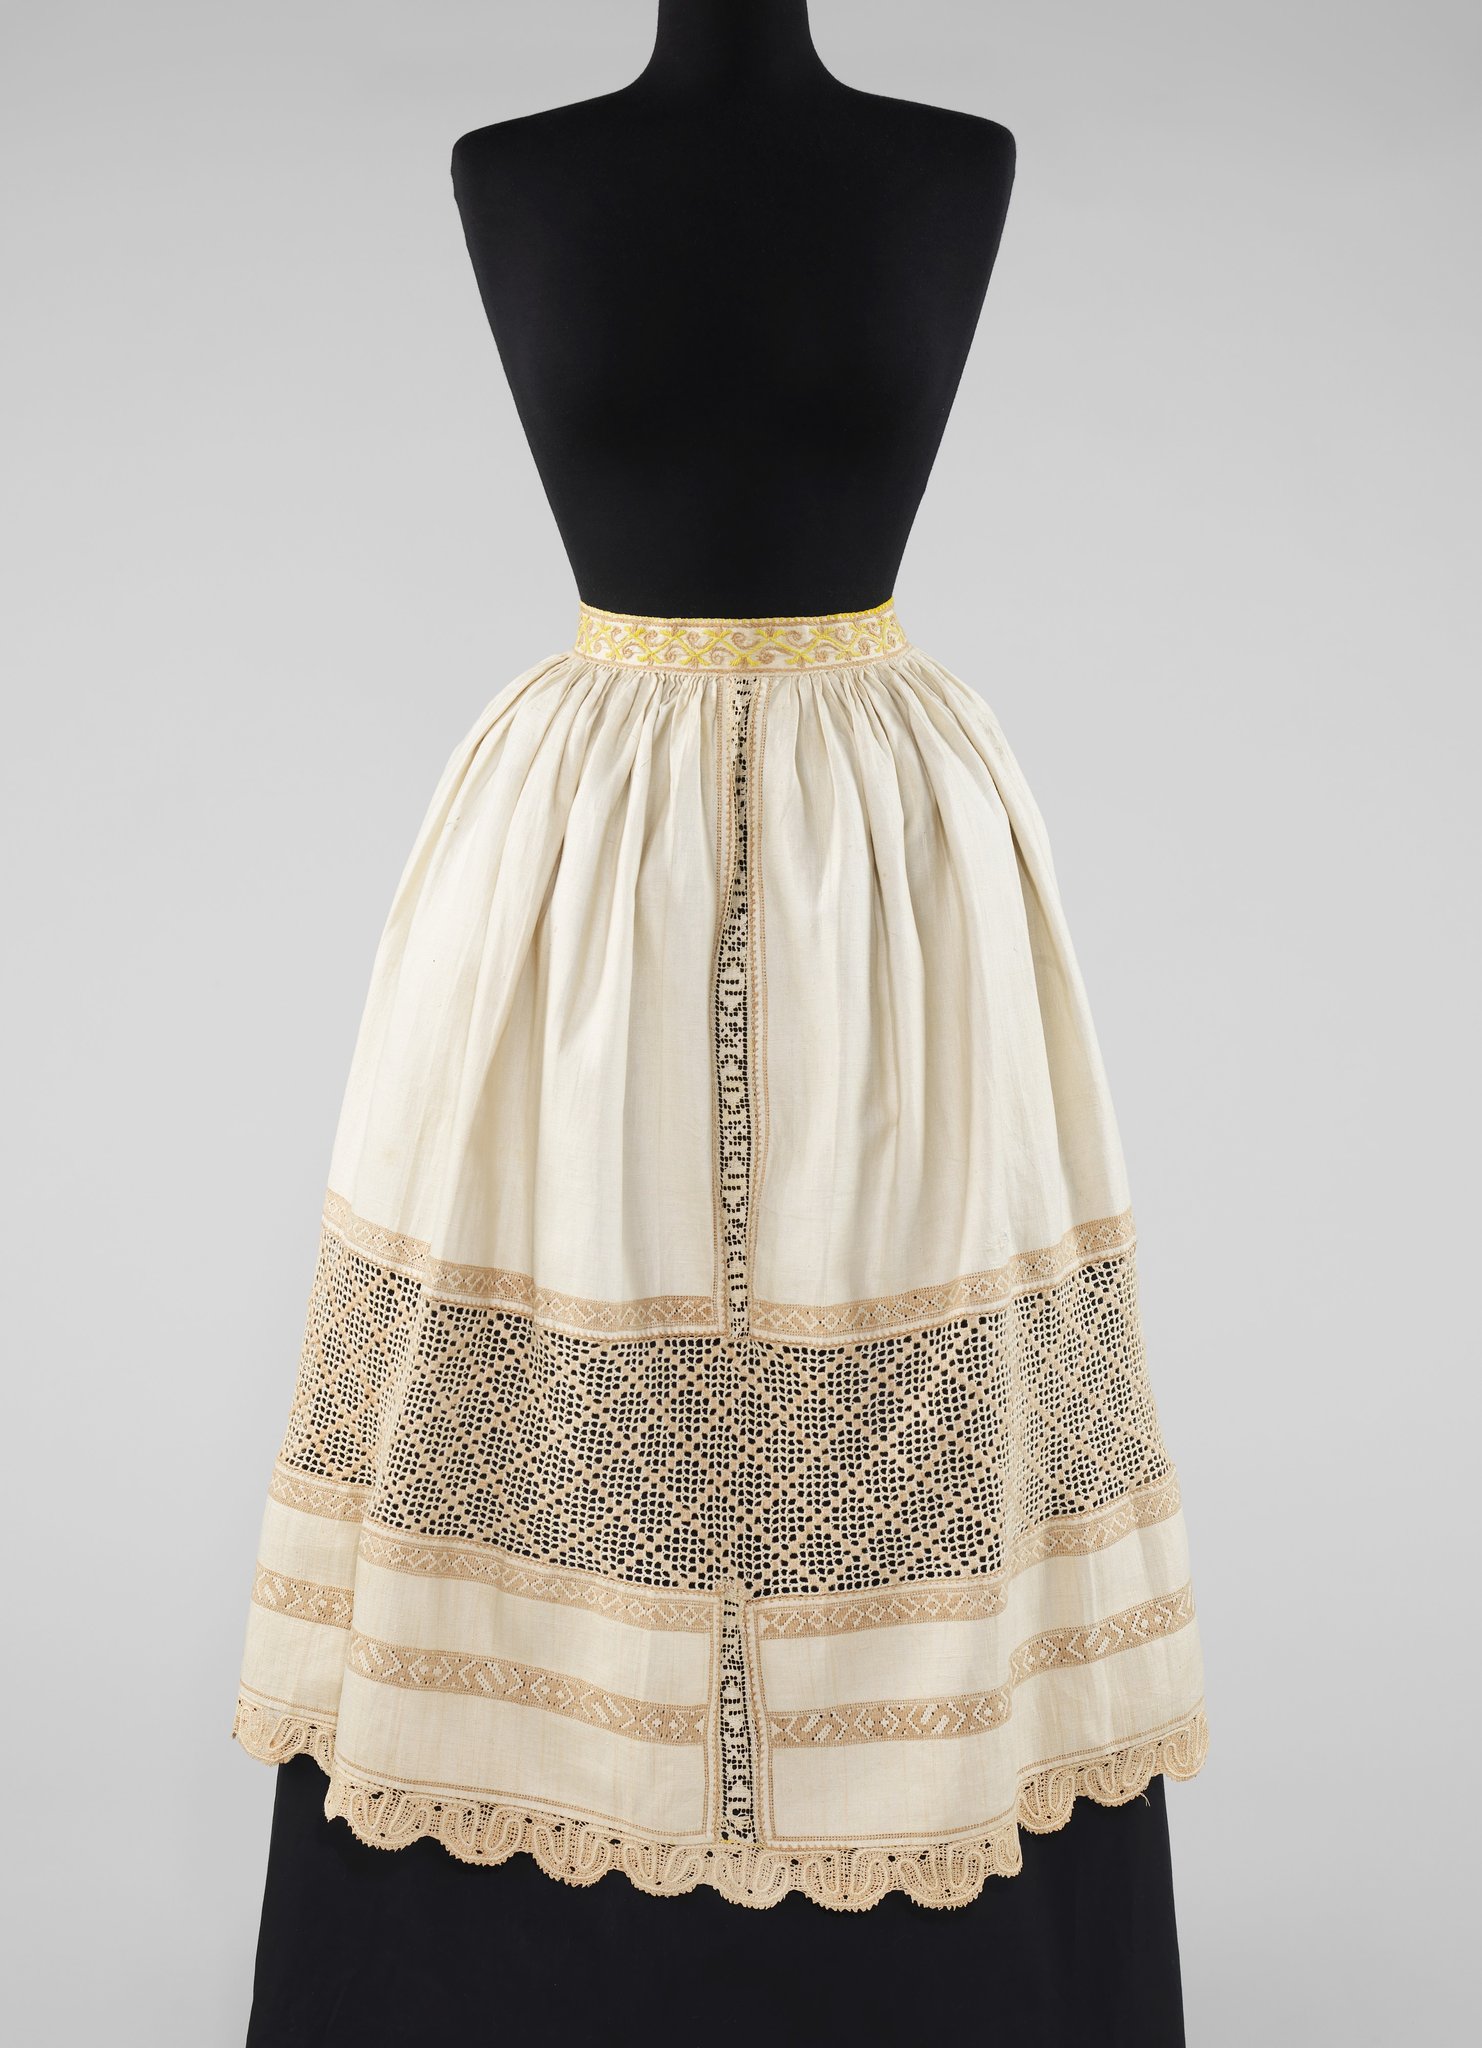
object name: apron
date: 1876-1900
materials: linen